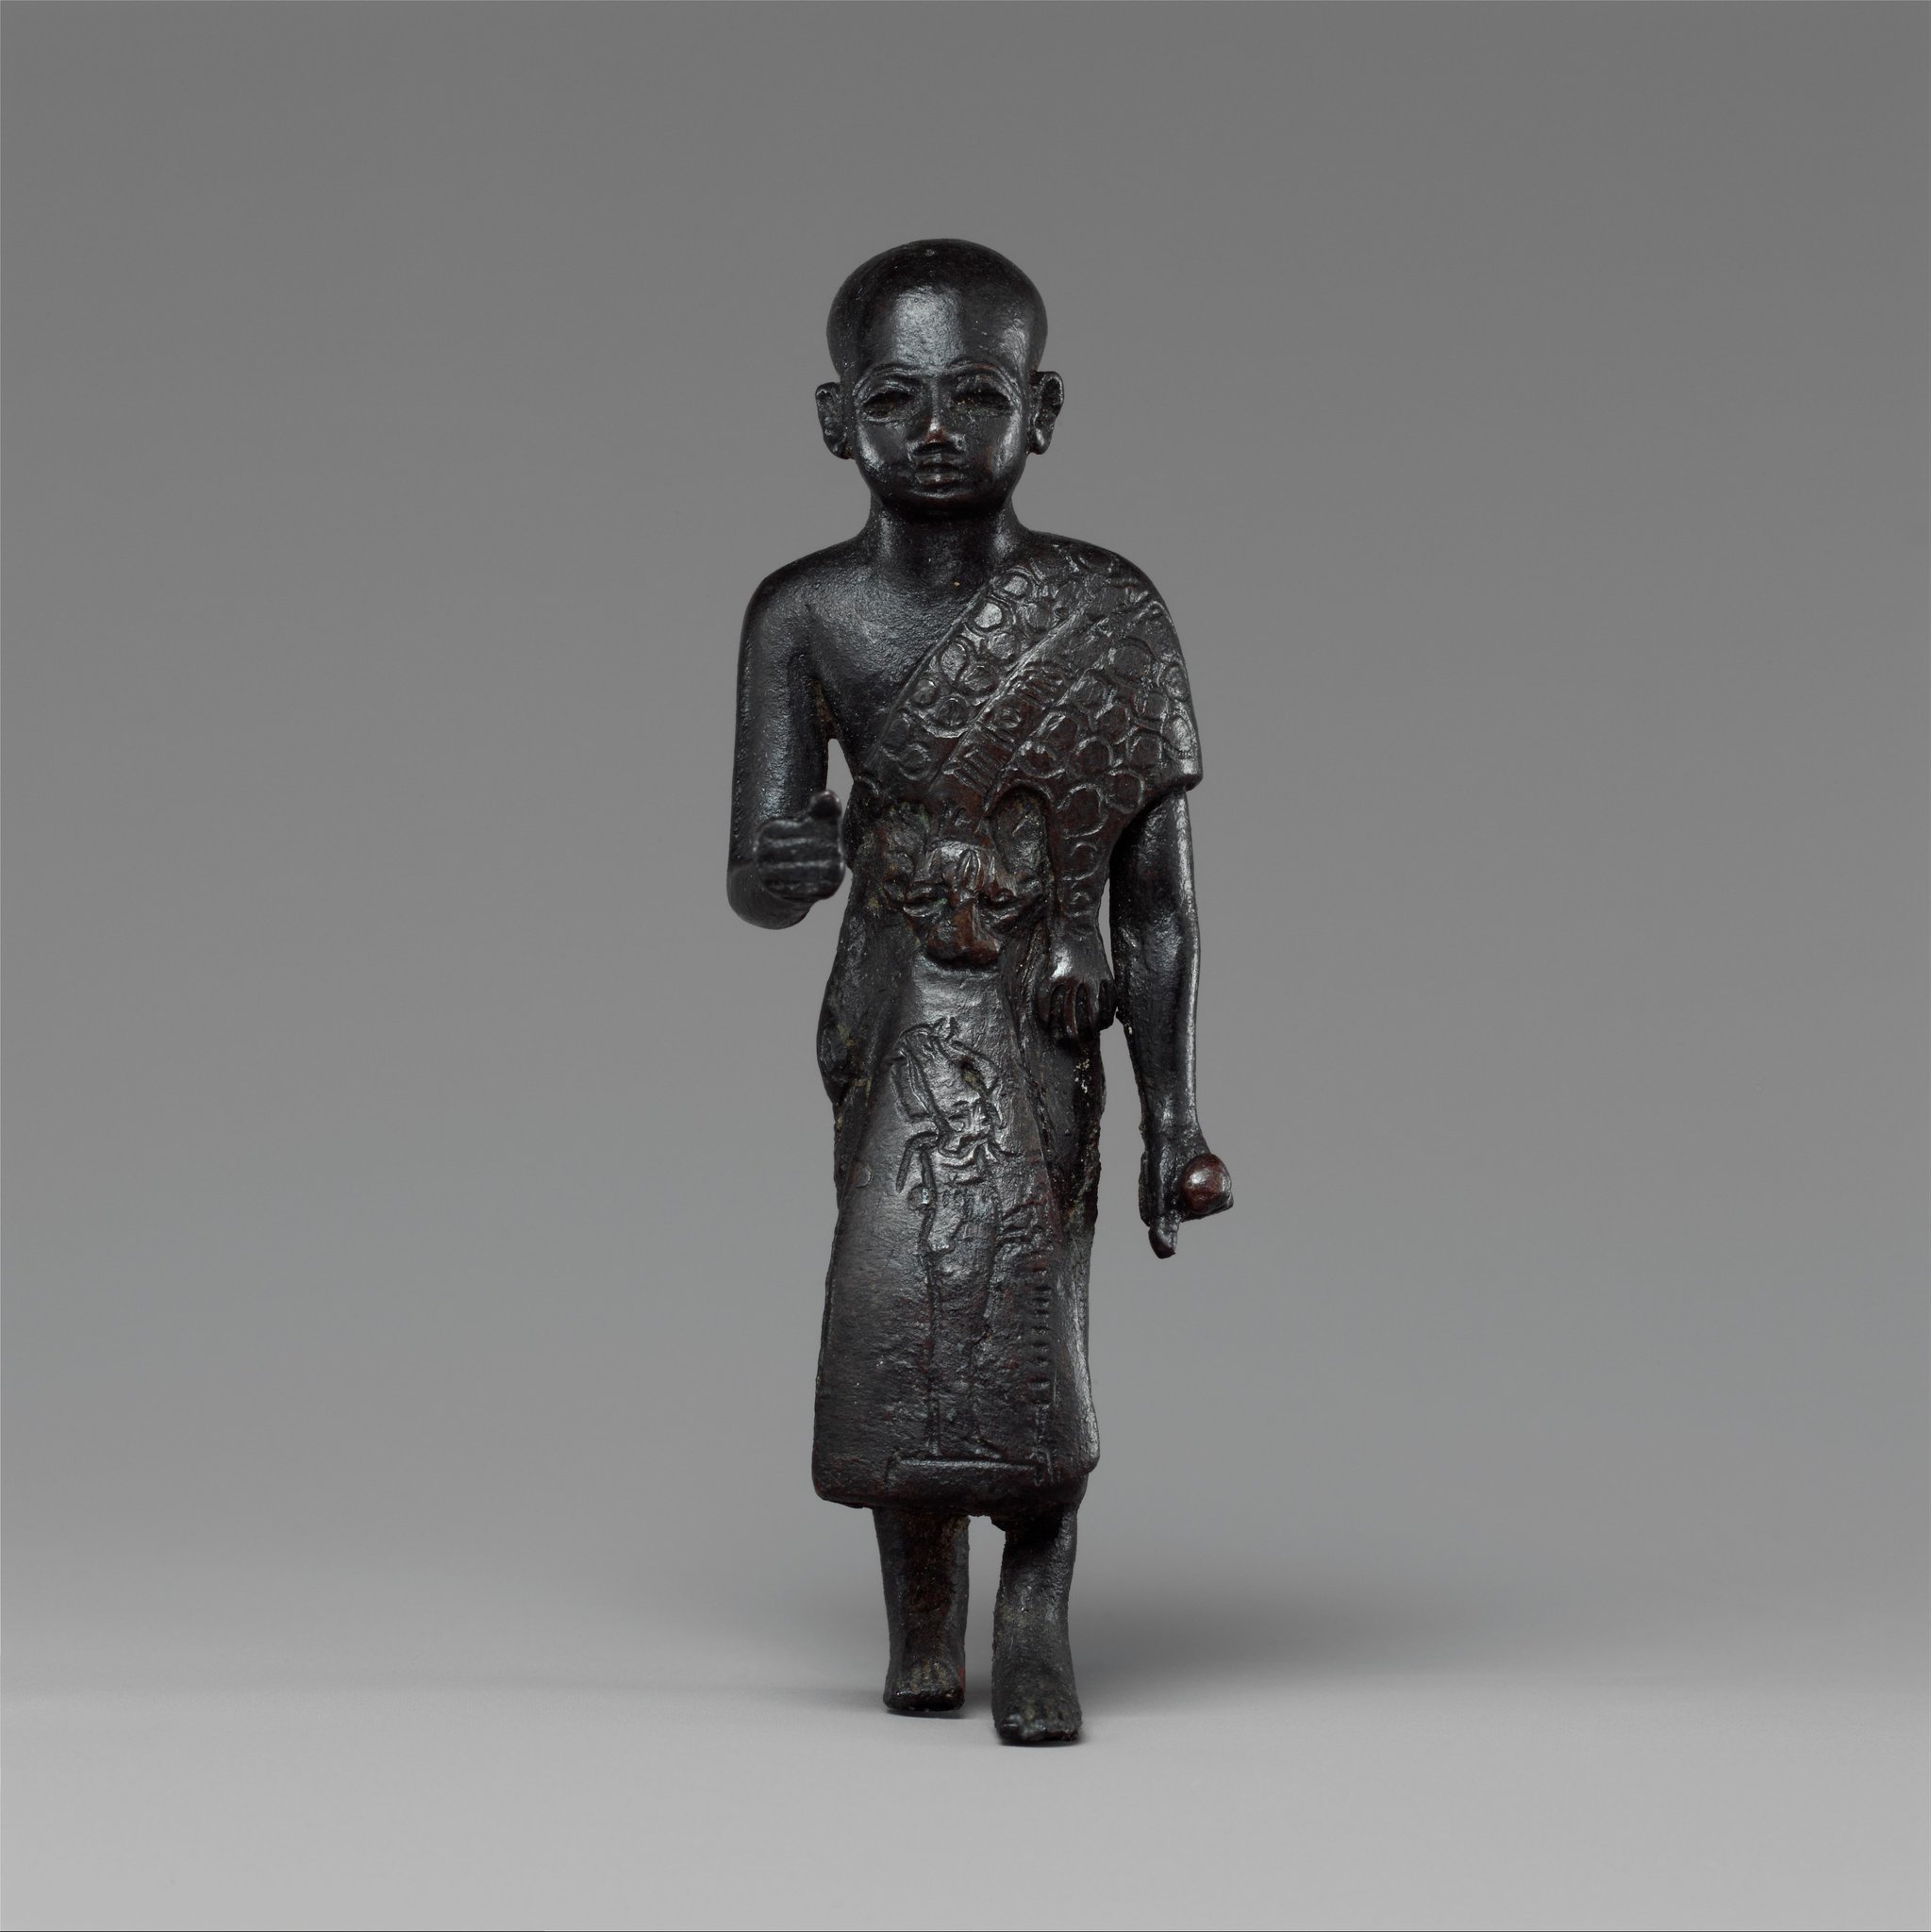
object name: statuette, standing priest, leopard cloak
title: Priest in a leopard skin cloak with an inscription and Osiris on his skirt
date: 712-650 BCE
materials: bronze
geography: egypt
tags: men